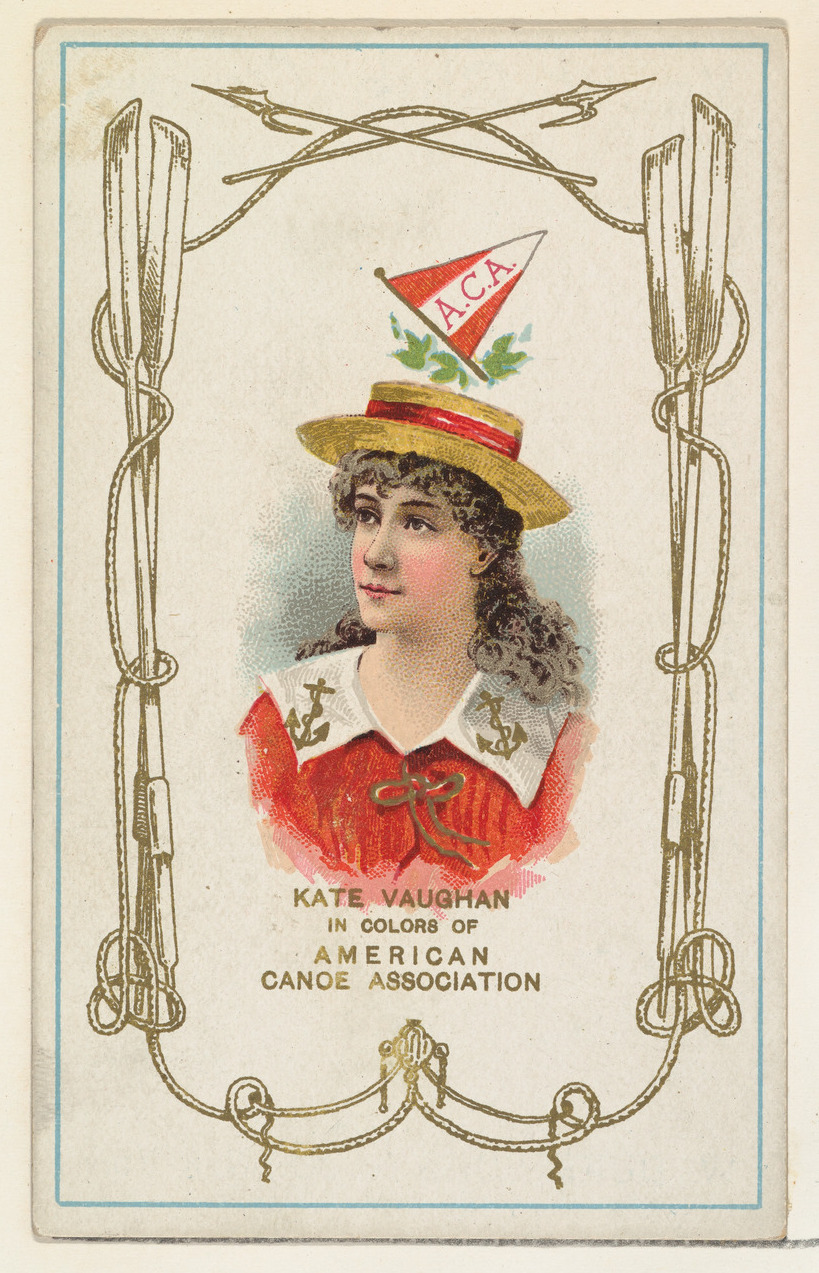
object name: print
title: Kate Vaughan in Colors of the American Canoe Association, from the Yacht Colors of the World series (N140) issued by Duke Sons & Co. to promote Honest Long Cut Tobacco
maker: w. duke, sons & co.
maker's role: publisher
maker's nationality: american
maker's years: 1870-1920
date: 1890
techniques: color lithograph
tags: portraits,women,flags